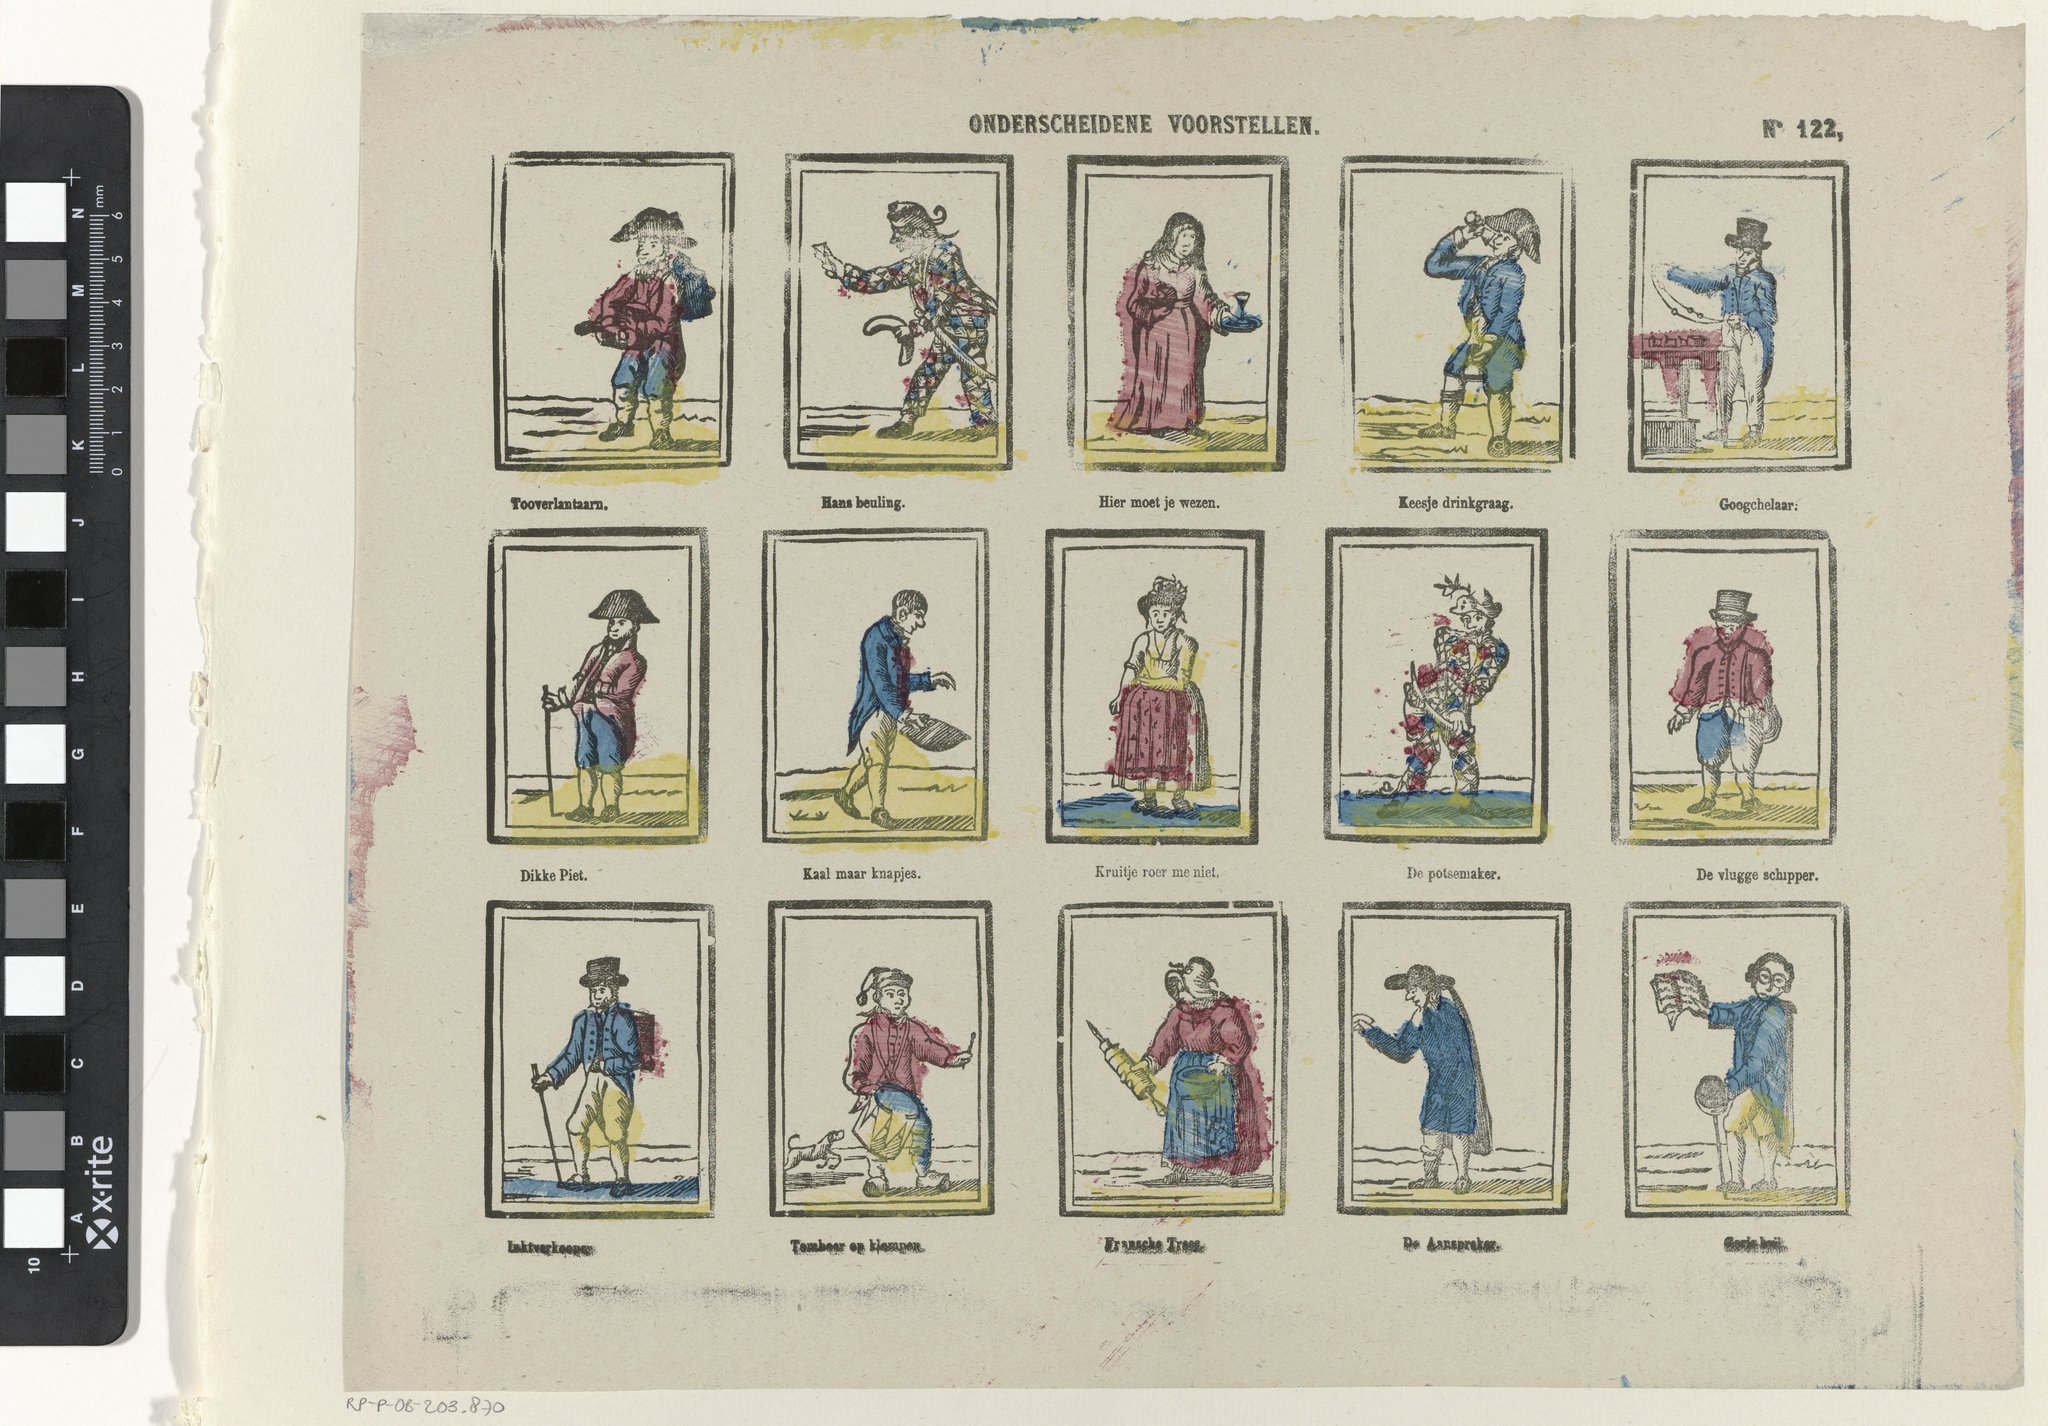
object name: popular print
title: Onderscheidenen voorstellen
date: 1827-1894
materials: paper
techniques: colour, letterpress printing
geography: schaarbeek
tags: characters (human types)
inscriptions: collector's mark: Lugt 2760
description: Blad met 15 voorstellingen van verschillende figuren en bezigheden. Onder elke afbeelding een onderschrift. Genummerd rechtsboven: No 122.